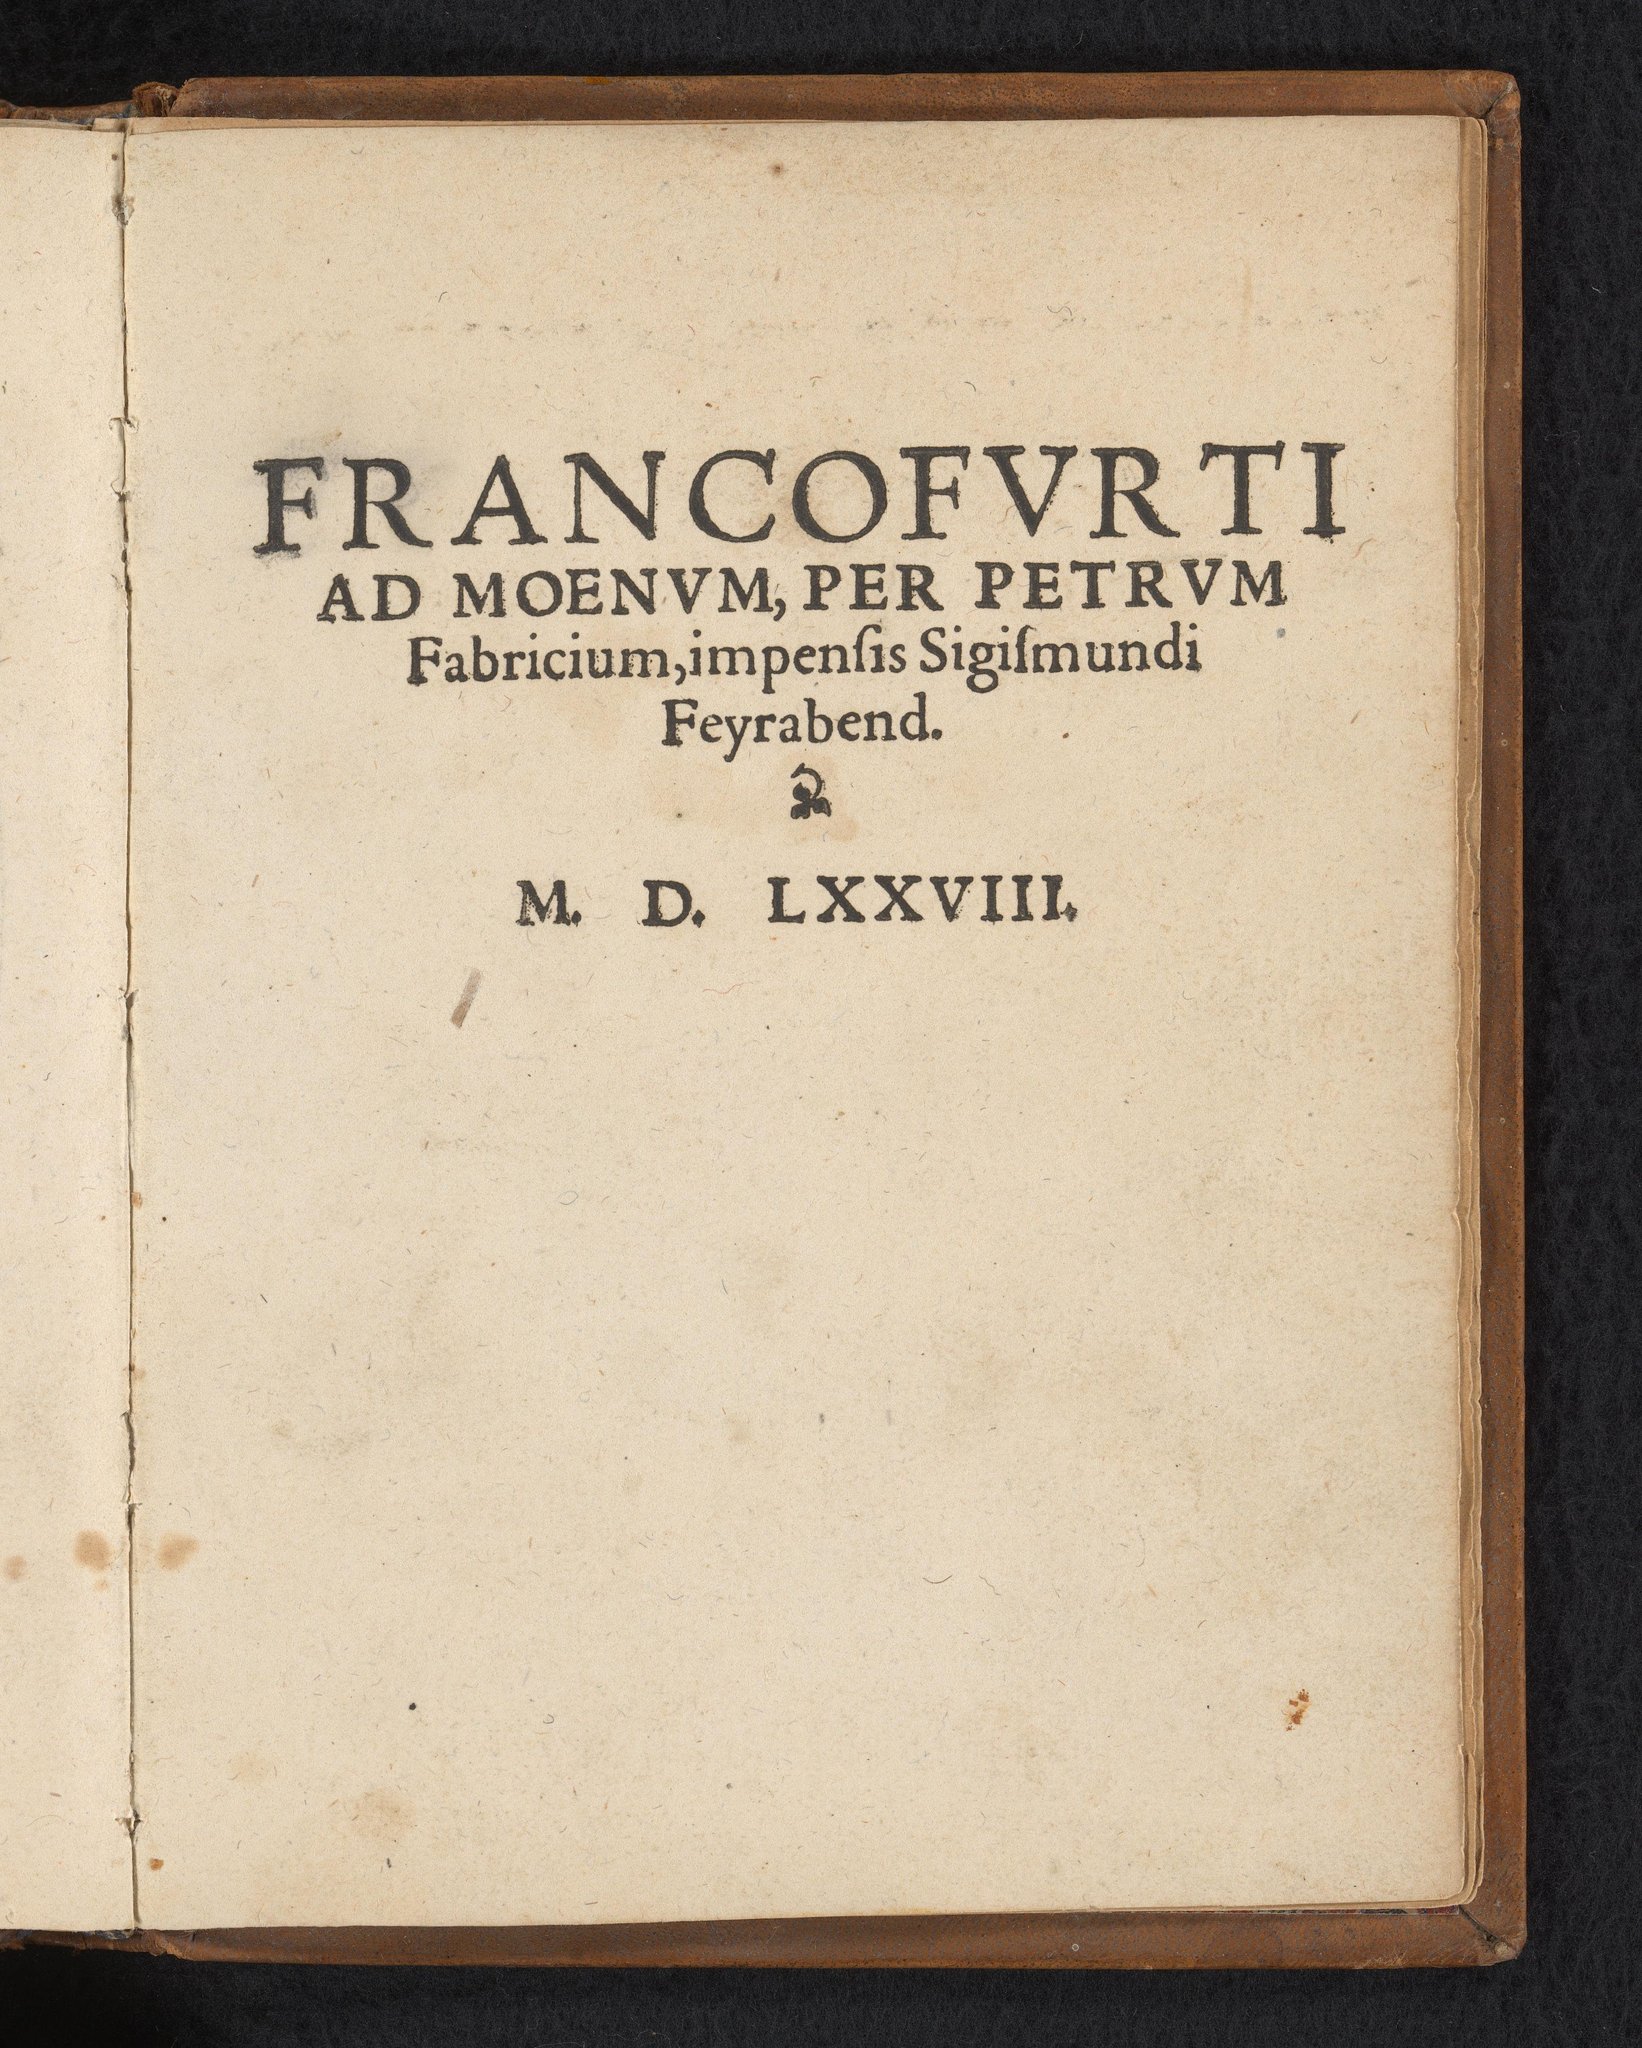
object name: colophon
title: Colofon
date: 1578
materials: paper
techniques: letterpress printing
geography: frankfurt am main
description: Colofon met naam en plaats van de uitgever en drukker en jaar van uitgave. Onderdeel van het modelboek Enchiridion artis pingendi, fingendi & sculpendi met 108 figuren bedoeld voor beginnende schilders, beeldhouwers en prentmakers.